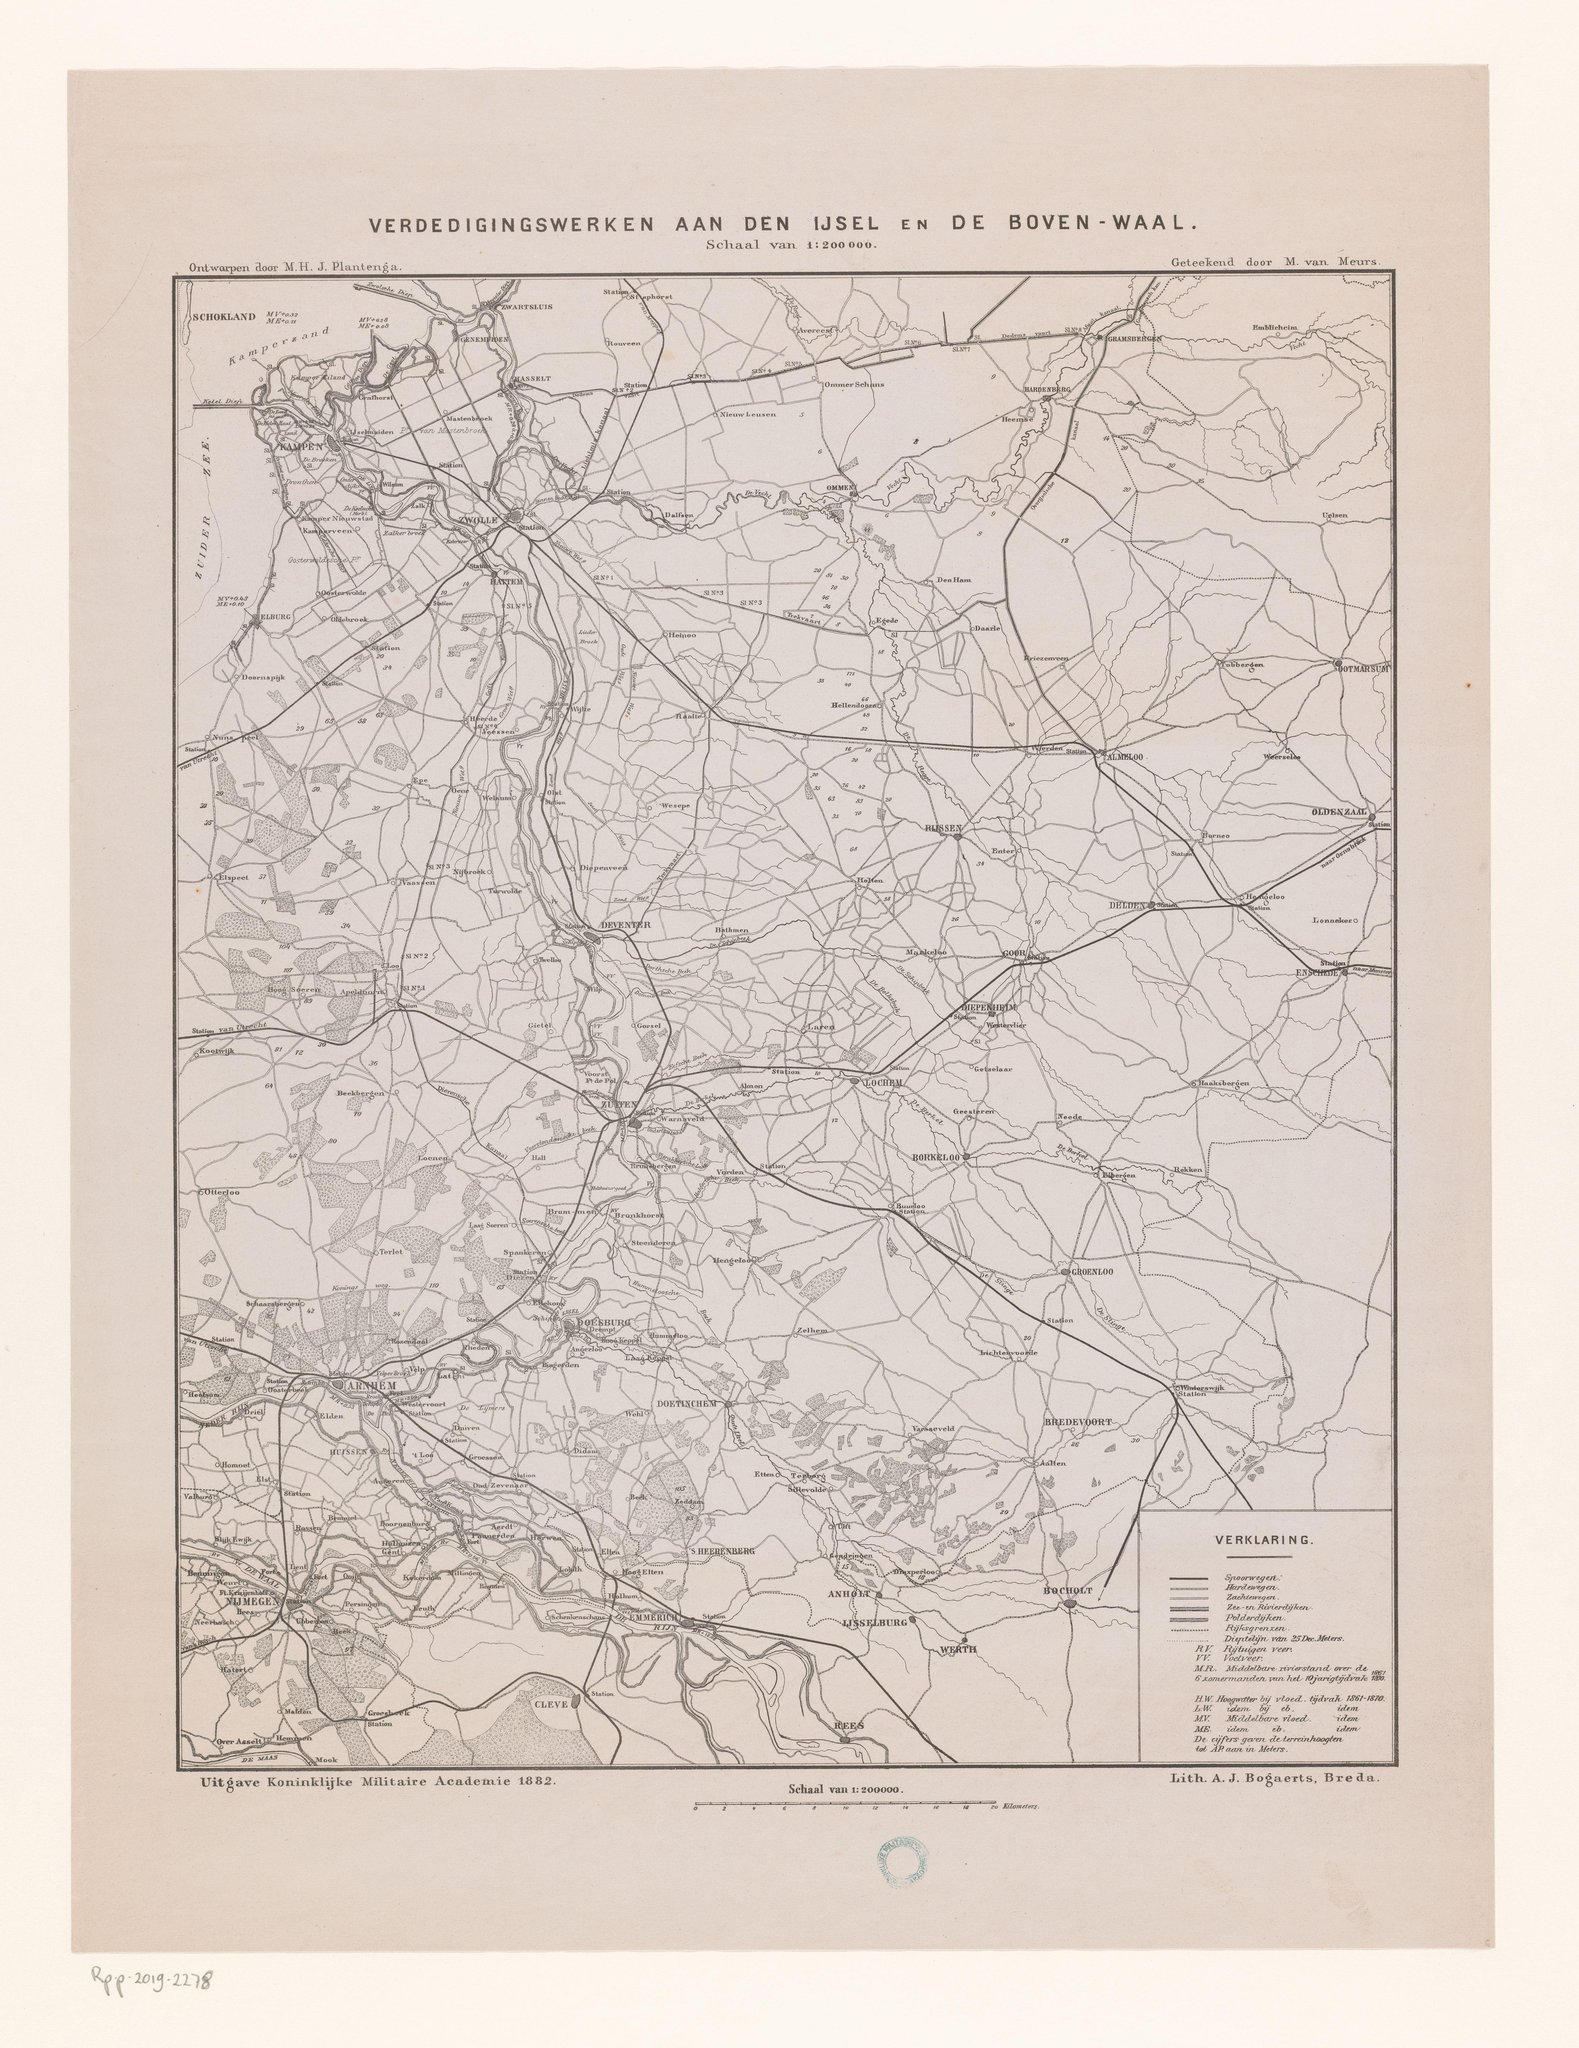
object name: map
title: Kaart met de verdedigingswerken aan de IJssel en de Waal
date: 1882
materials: paper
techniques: lithograph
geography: amsterdam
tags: maps of separate countries or regions, river, dikes, levee, gelderland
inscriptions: collector's mark: Lugt 2228, collector's mark: ‘Koninklijke Militaire Akademie’